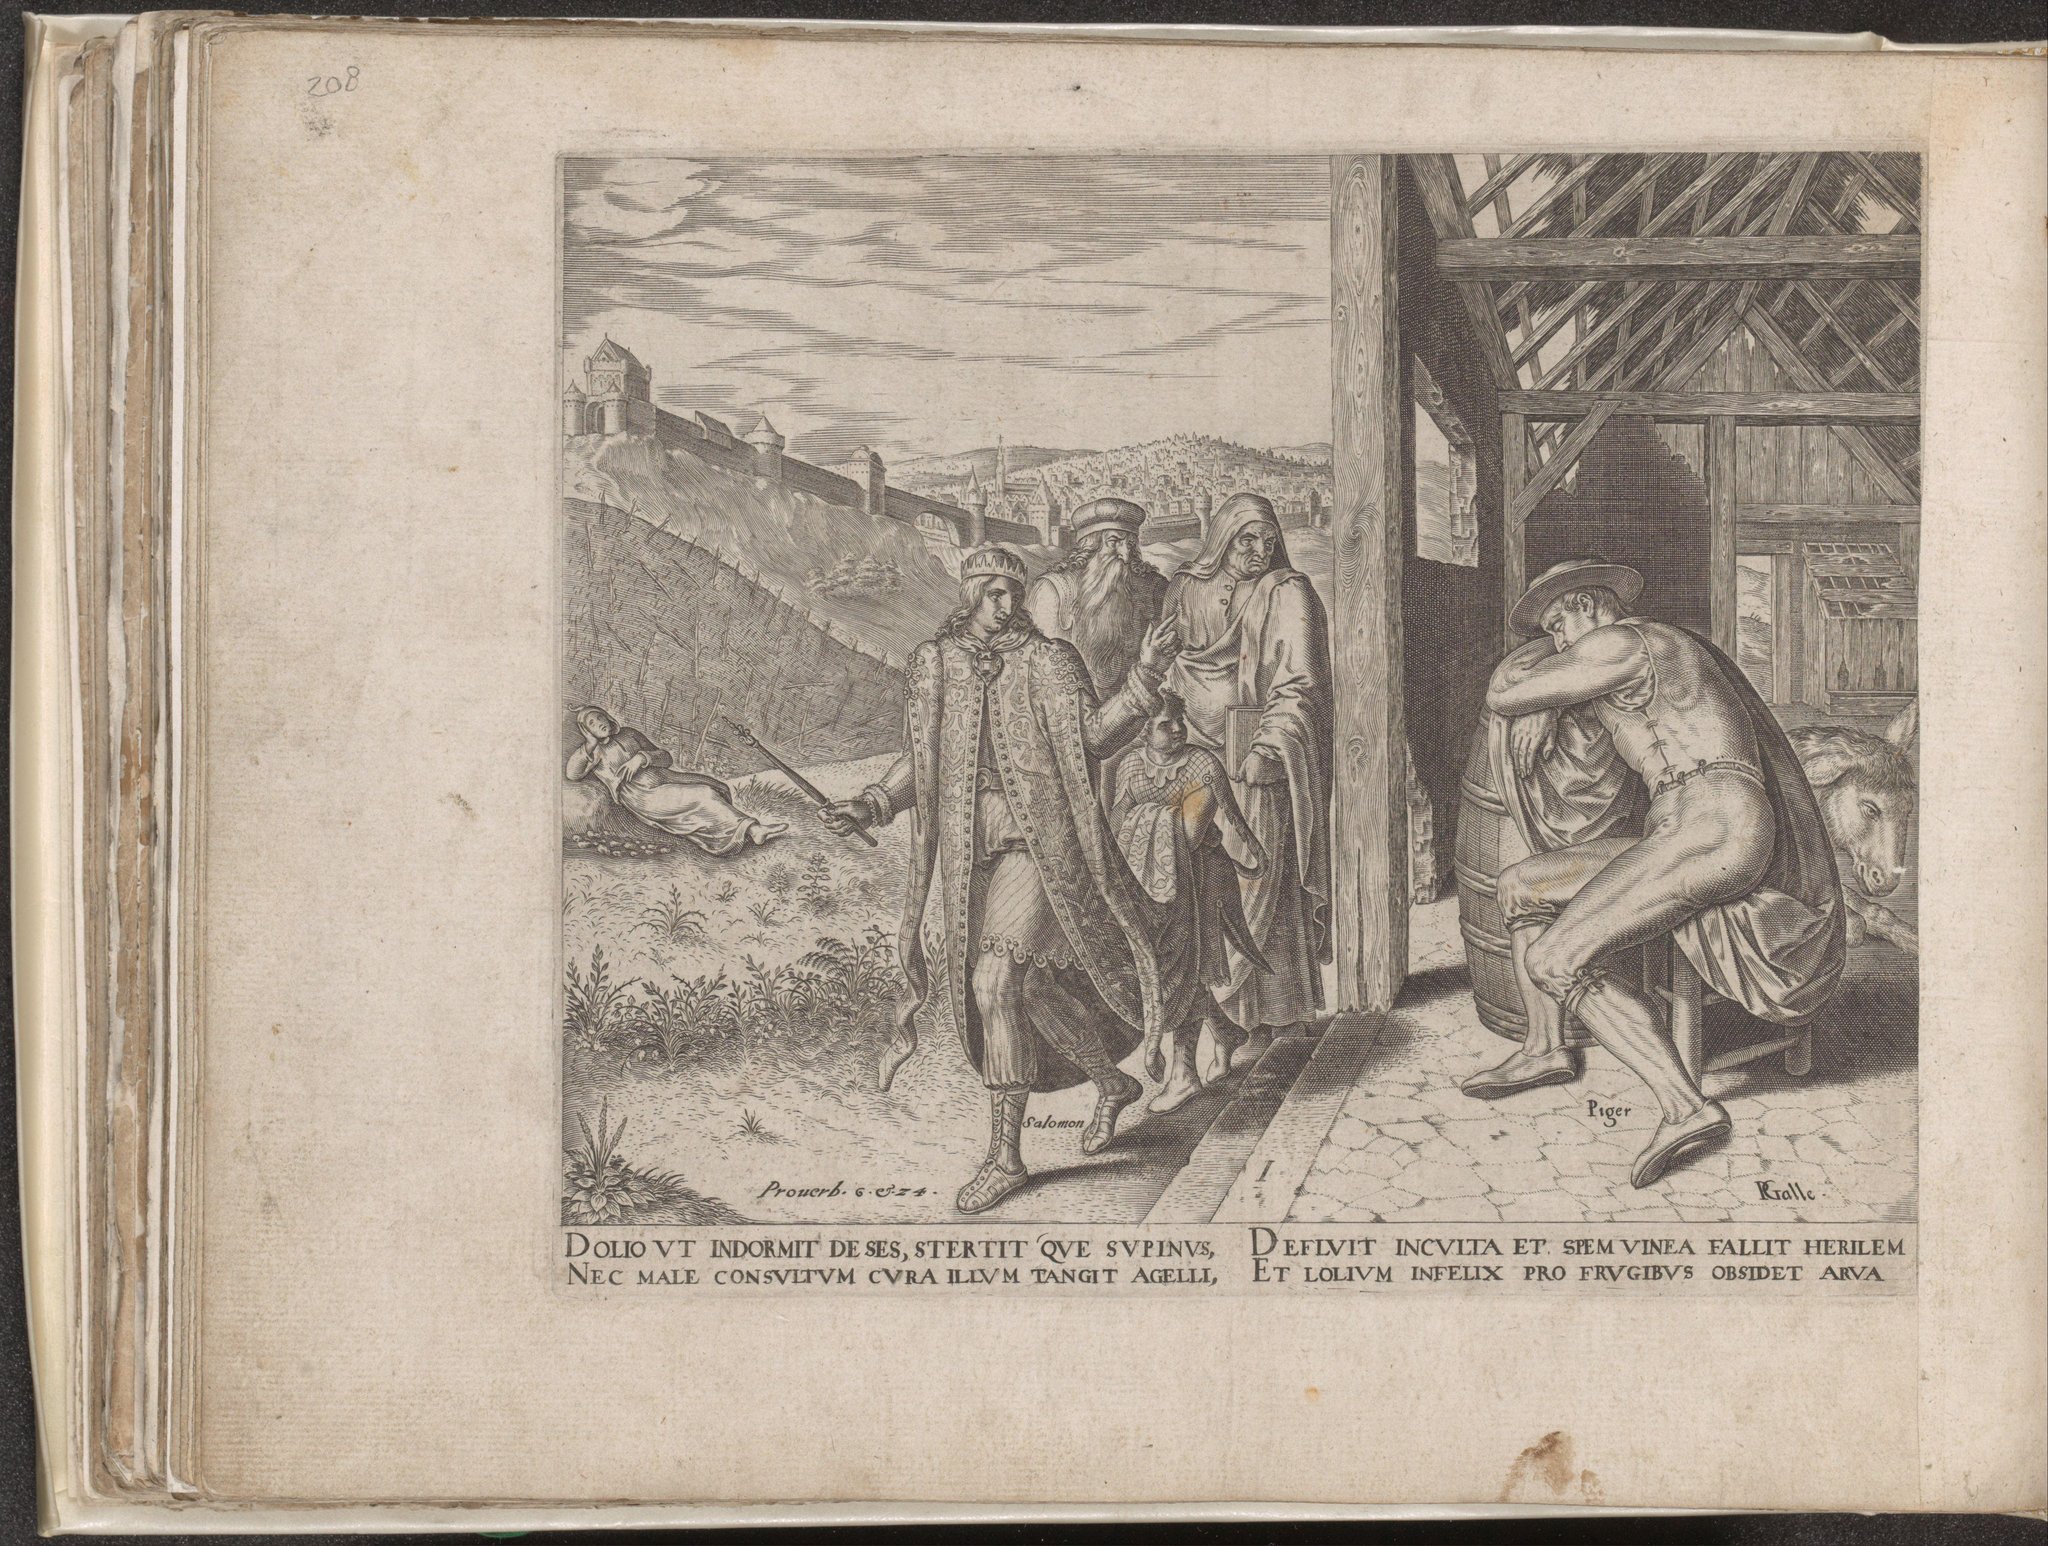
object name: album leaf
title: Verhaal van de luiaard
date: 1563-1567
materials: paper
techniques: engraving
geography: haarlem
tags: the book of proverbs, sluggard, solomon as teacher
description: Koning Salomo loopt door een wijngaard en wijst zijn gezelschap op een luiaard die op klaarlichte dag in een stal slaapt, terwijl zijn wijngaard vergaat. Een tweede luiaard ligt in het veld te slapen. Naar de Bijbelteksten in Spr. 6:9 en Spr. 24:30-31. Onder de voorstelling een verklarende tekst in het Latijn. Deze prent maakt deel uit van een album.